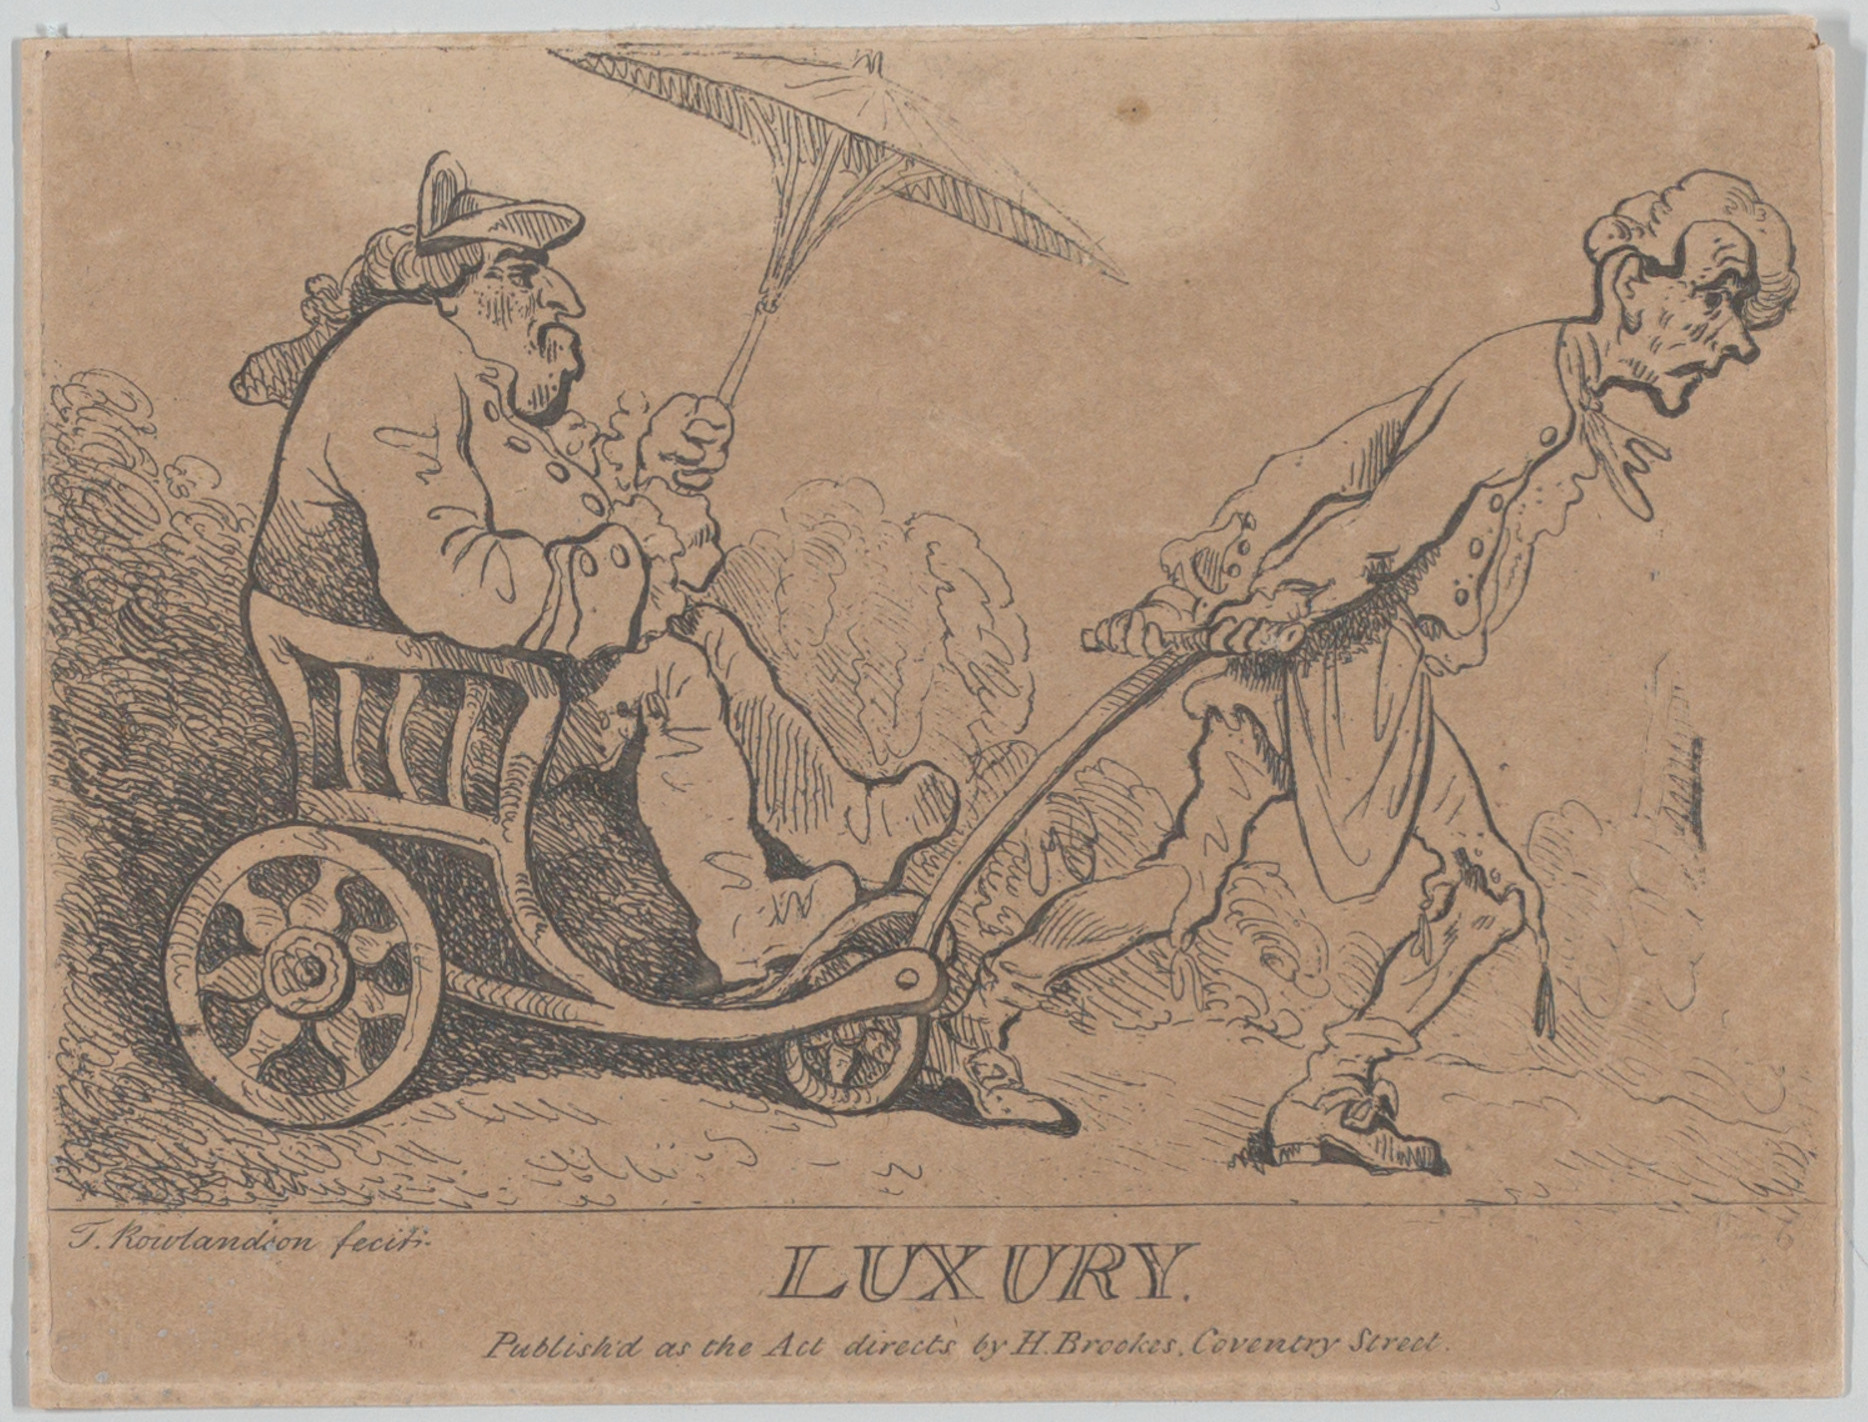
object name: print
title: Luxury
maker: thomas rowlandson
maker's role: artist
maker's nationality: british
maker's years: 1757-1827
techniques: etching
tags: satire,men